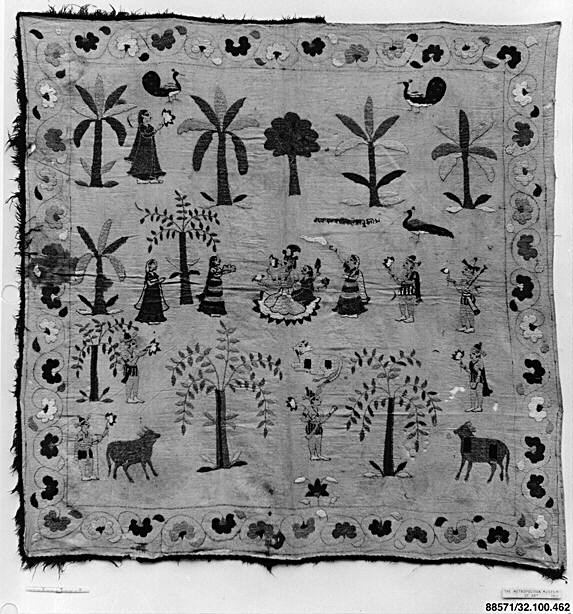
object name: cover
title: Cover (Rumal)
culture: indian, himachal pradesh, chamba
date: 1701-1800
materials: cotton, silk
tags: animals,women,trees